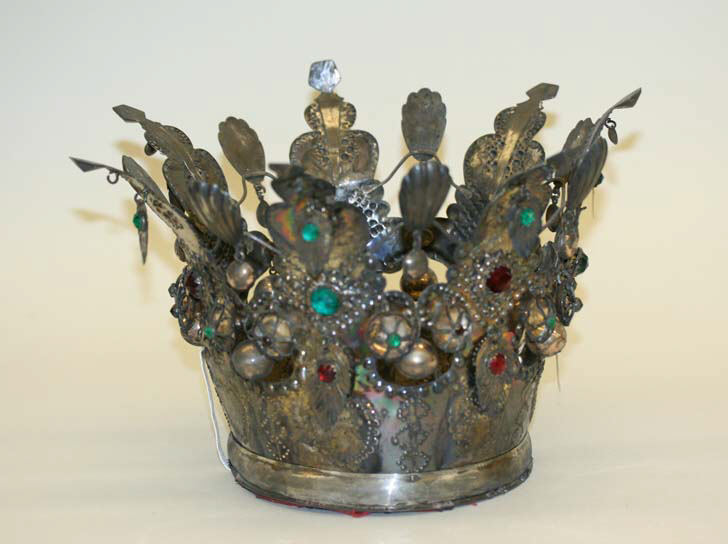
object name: wedding crown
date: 1801-1900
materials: silver, stone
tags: crowns